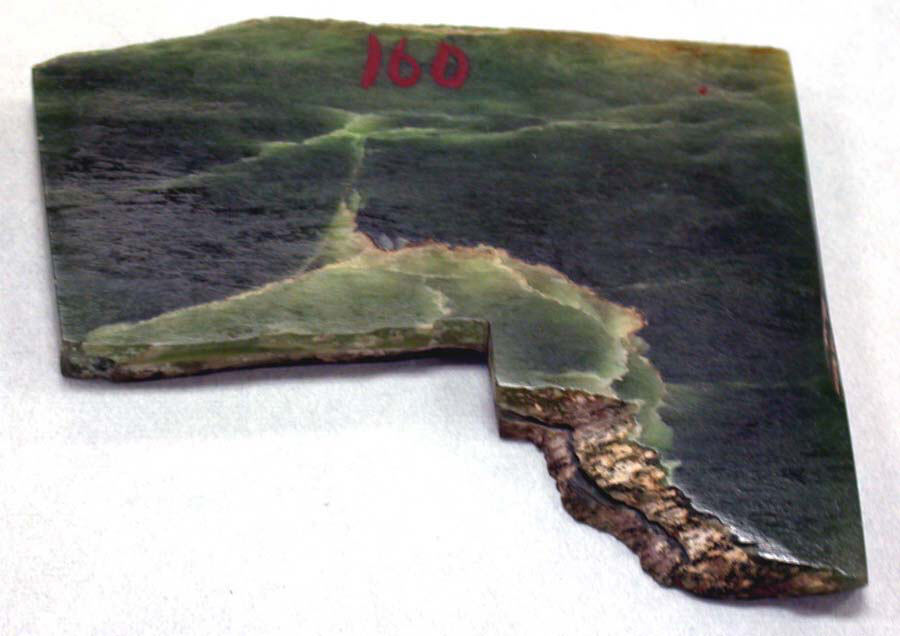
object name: fragment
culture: new zealander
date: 1902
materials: jade